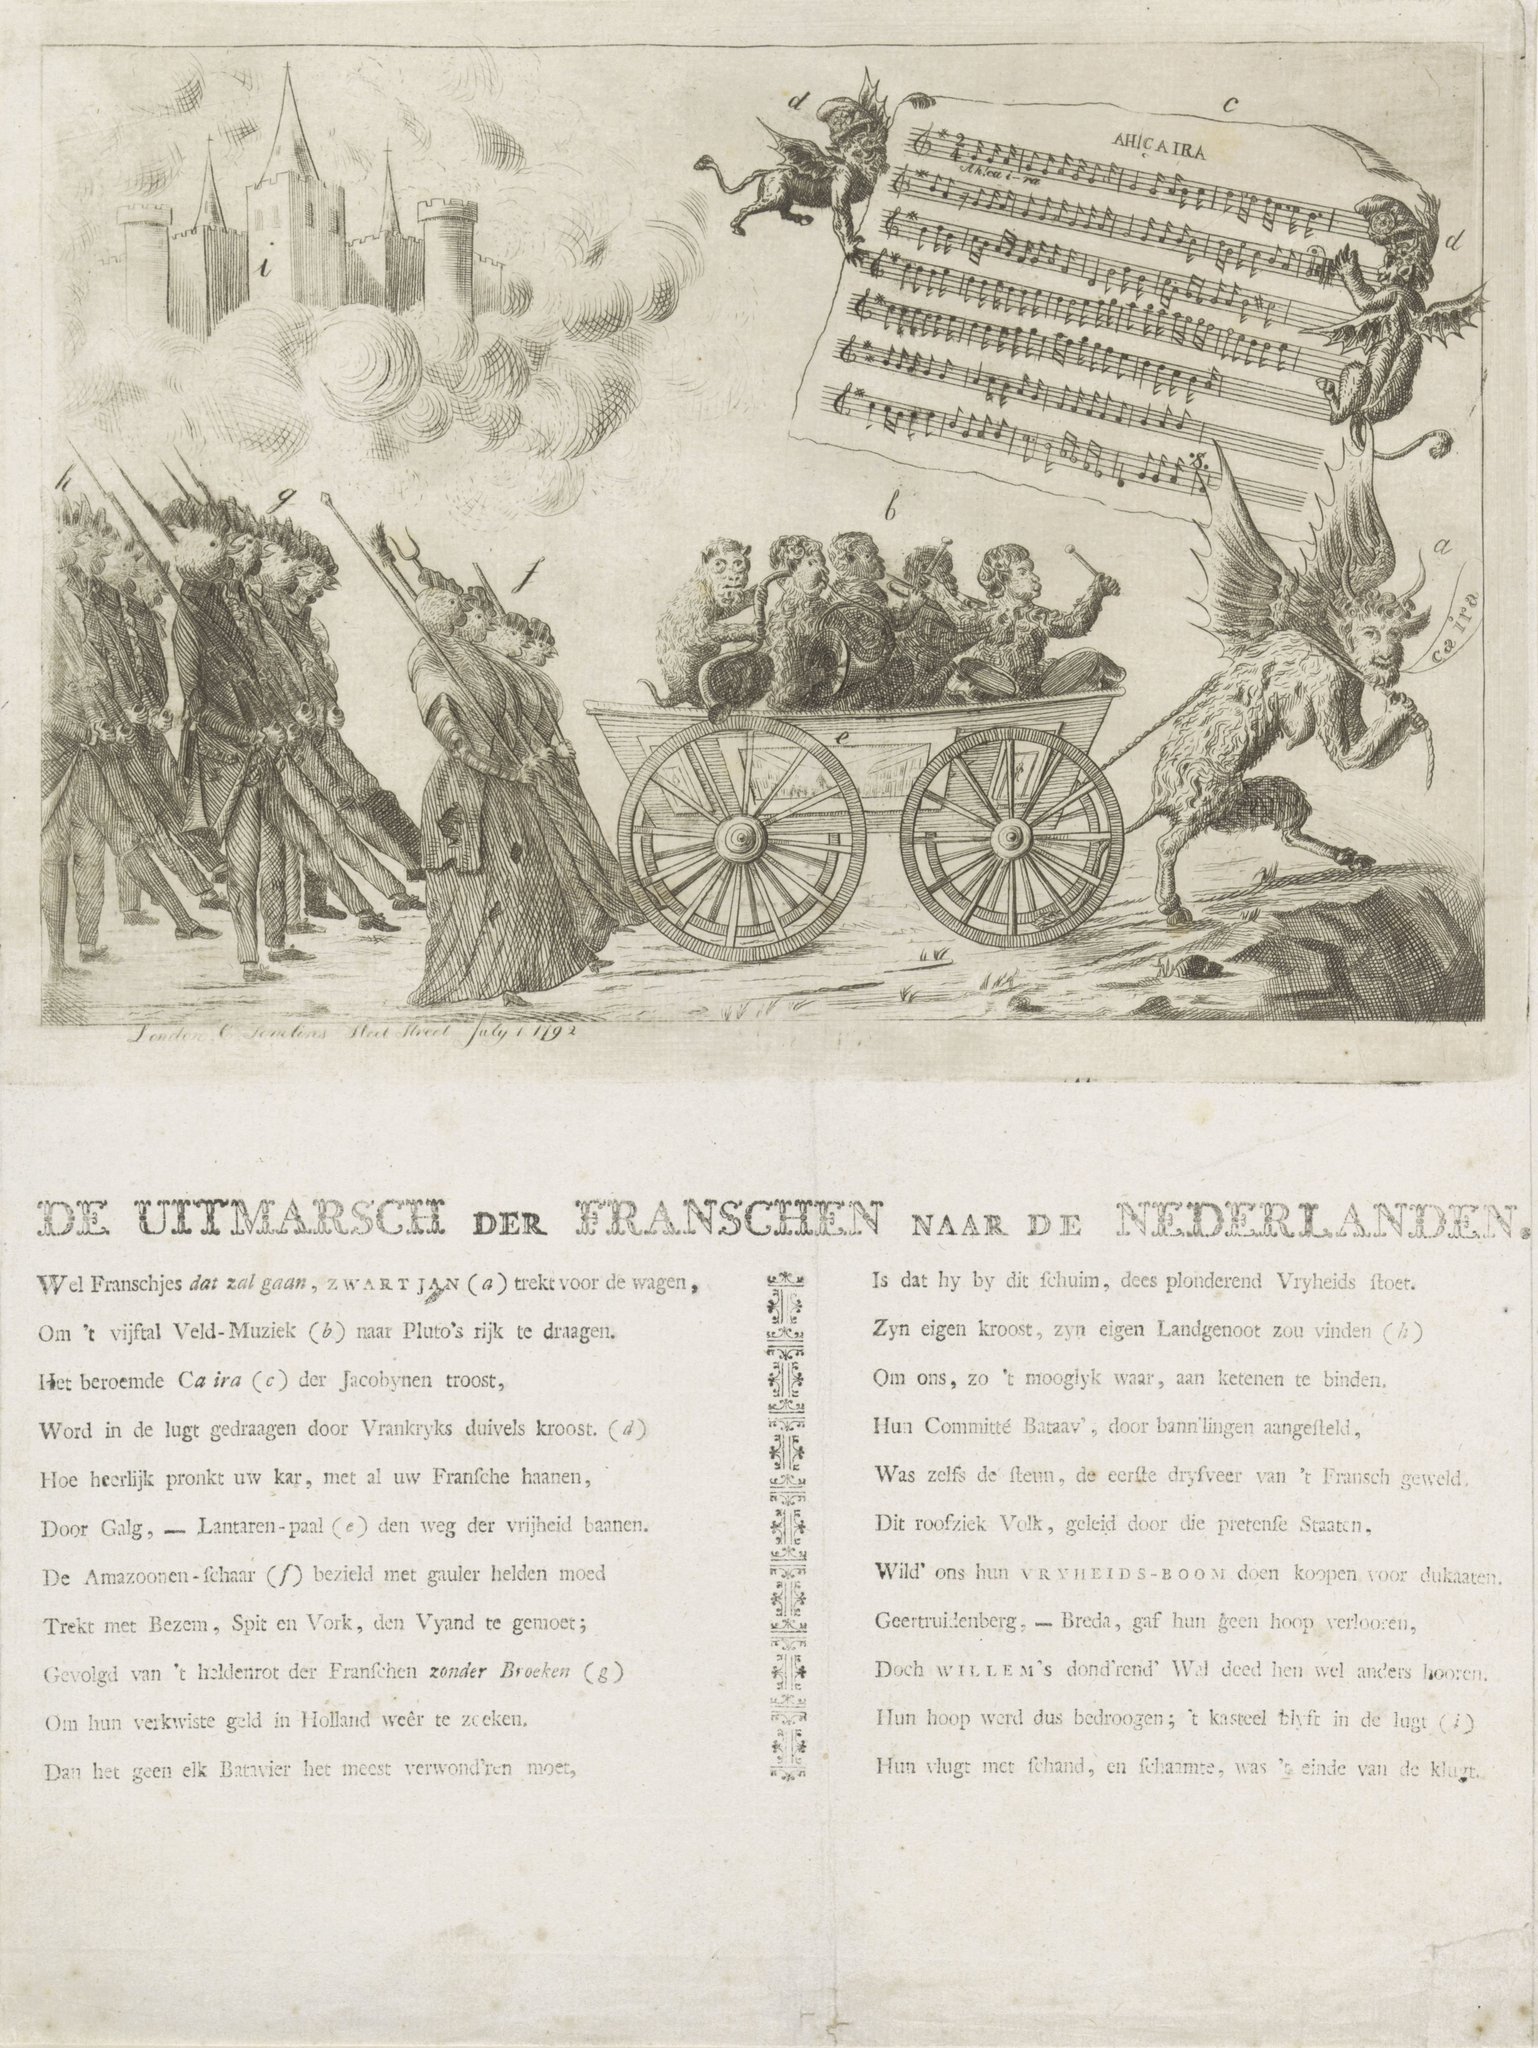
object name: print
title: Mislukte mars van de Fransen naar de Nederlanden, 1793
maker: c. tomlins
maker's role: publisher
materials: paper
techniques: engraving, etching, letterpress printing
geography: london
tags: notation of music, monkeys, apes, animals acting as human beings, devil(s) and demons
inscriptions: collector's mark: Lugt 2228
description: De duivel trekt een kar met een orkest van apen in de richting van een afgrond (de hel). Daarachter marcheren de Franse revolutionaire troepen als hanen, de sansculotten. In de lucht houden twee duivels met Jacobijnenmutsen een muziekblad omhoog waarop de noten van het lied 'Ah! ca ira'. In de wolken zweeft een kasteel, mogelijk de Bastille. Op het blad onder de plaat een vers in twee kolommen waarin de legenda a-i en een uitleg van de voorstelling. Heruitgave naar aanleiding van het vertrek van de Fransen uit de Nederlanden in 1793.